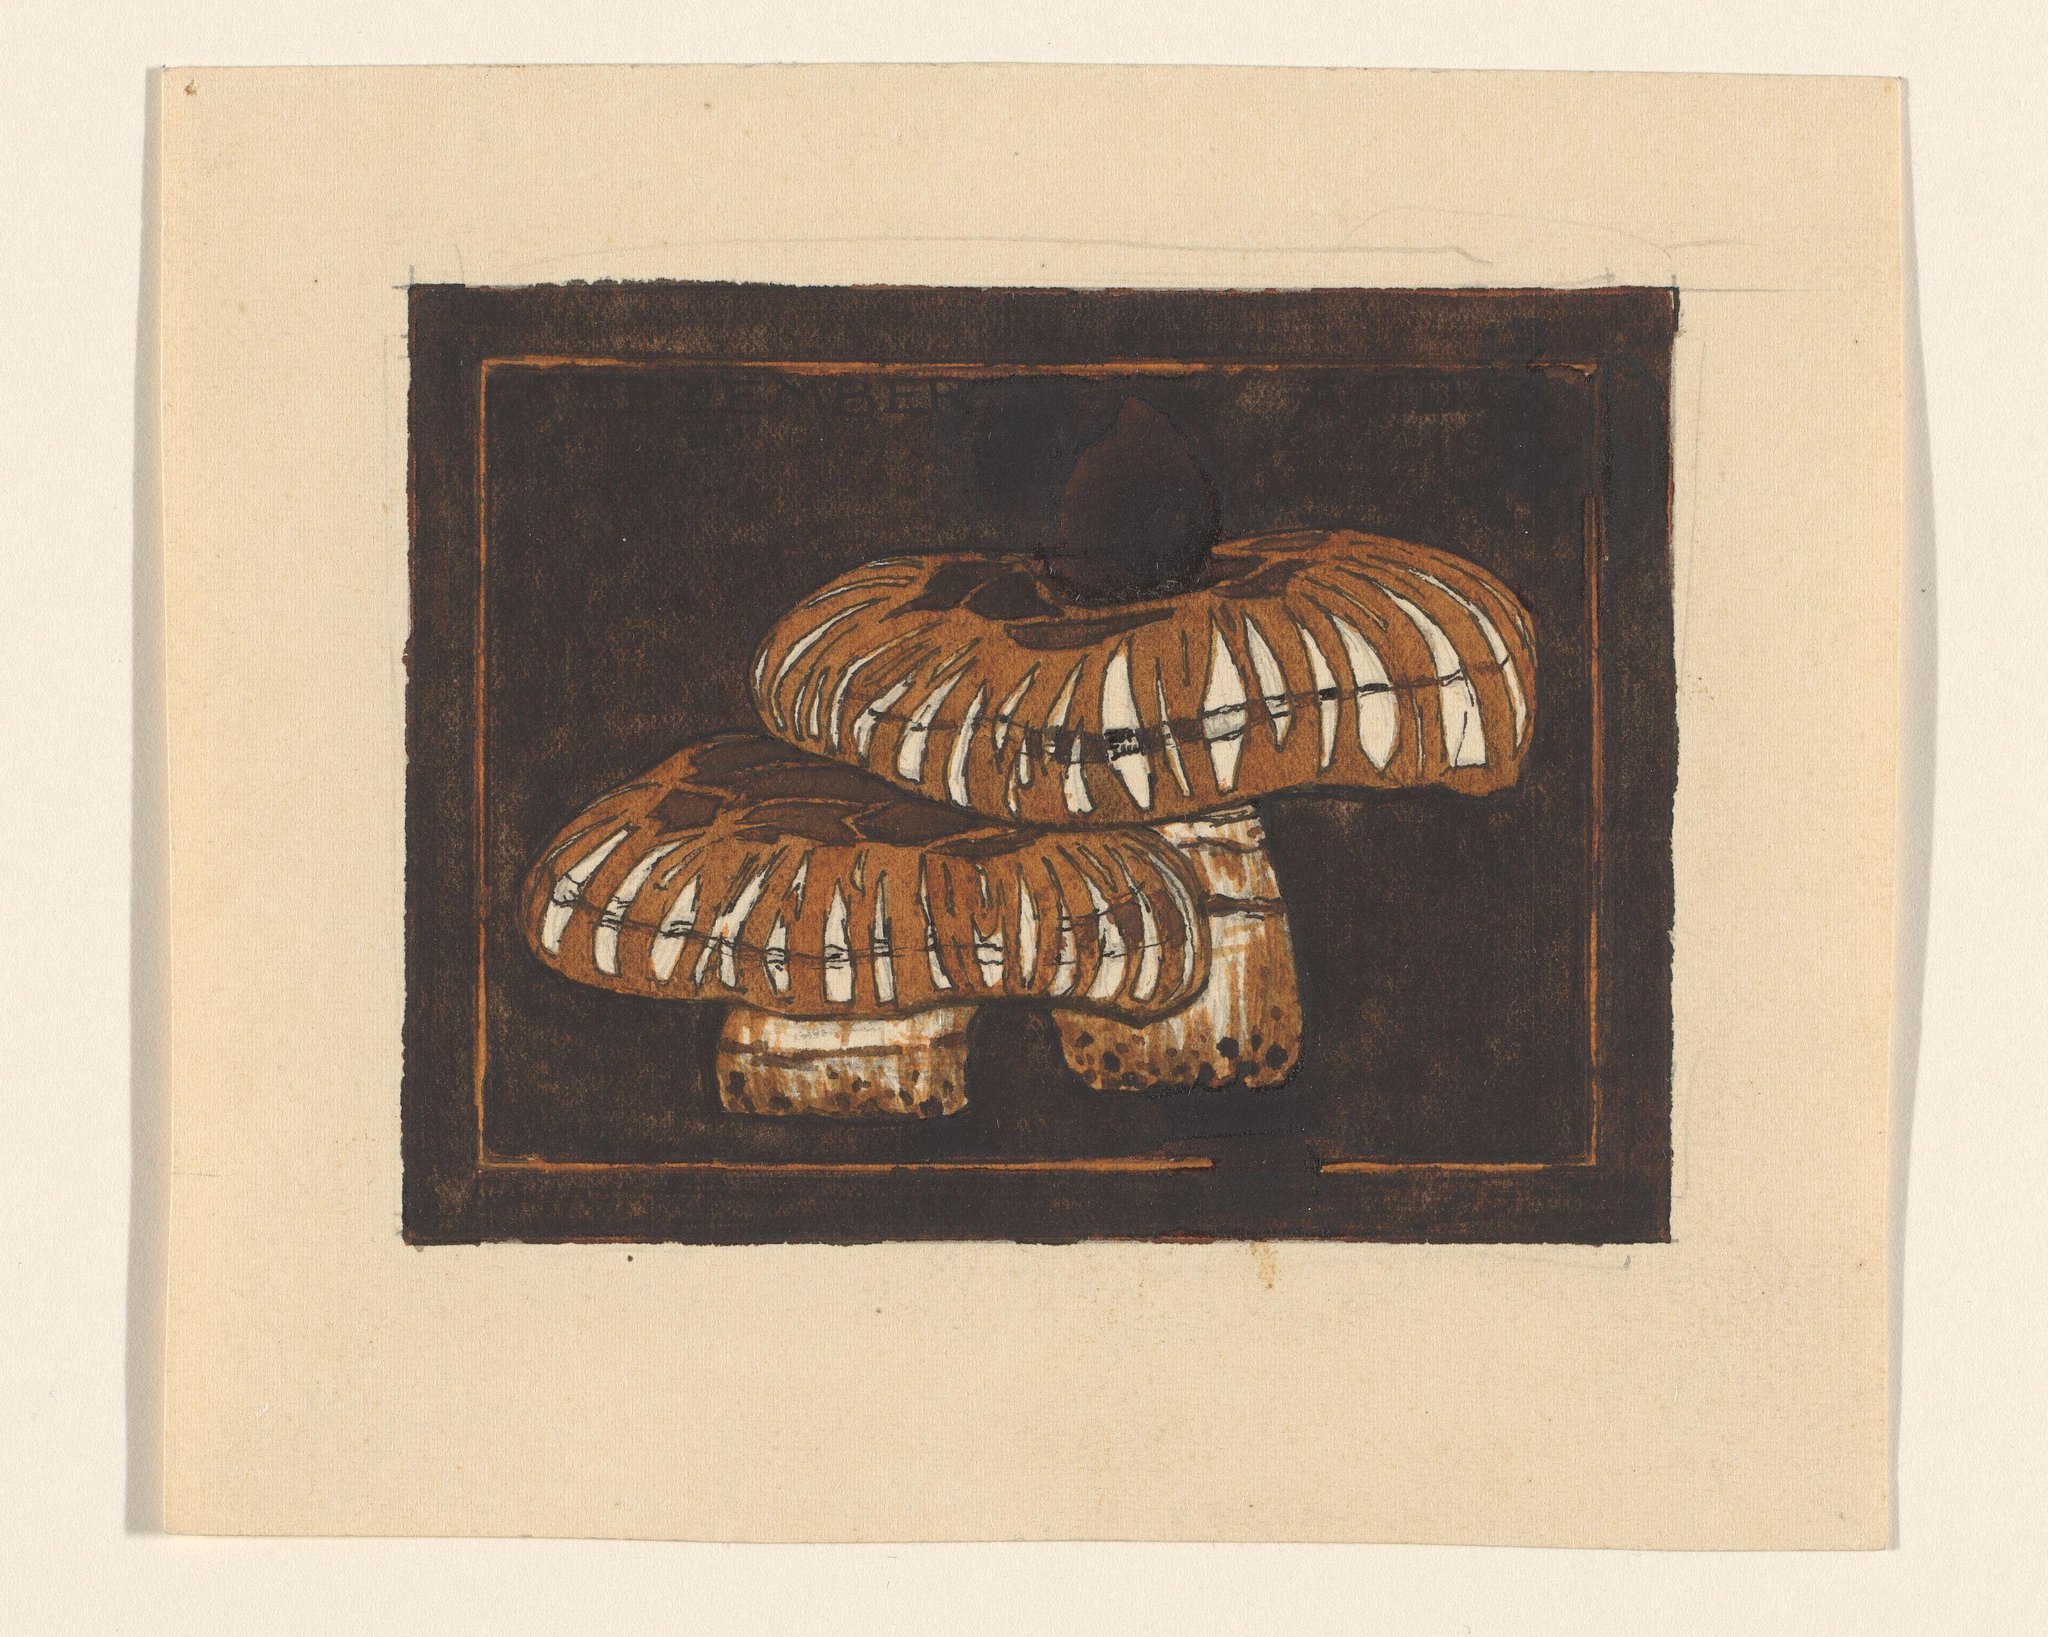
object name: drawing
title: Twee paddenstoelen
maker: julie de graag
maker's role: draughtsman, print maker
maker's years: 1877-1924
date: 1887-1924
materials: ink, paper, pencil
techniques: brush, pen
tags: mushrooms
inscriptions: number: ‘98’, annotation: ‘15.-’